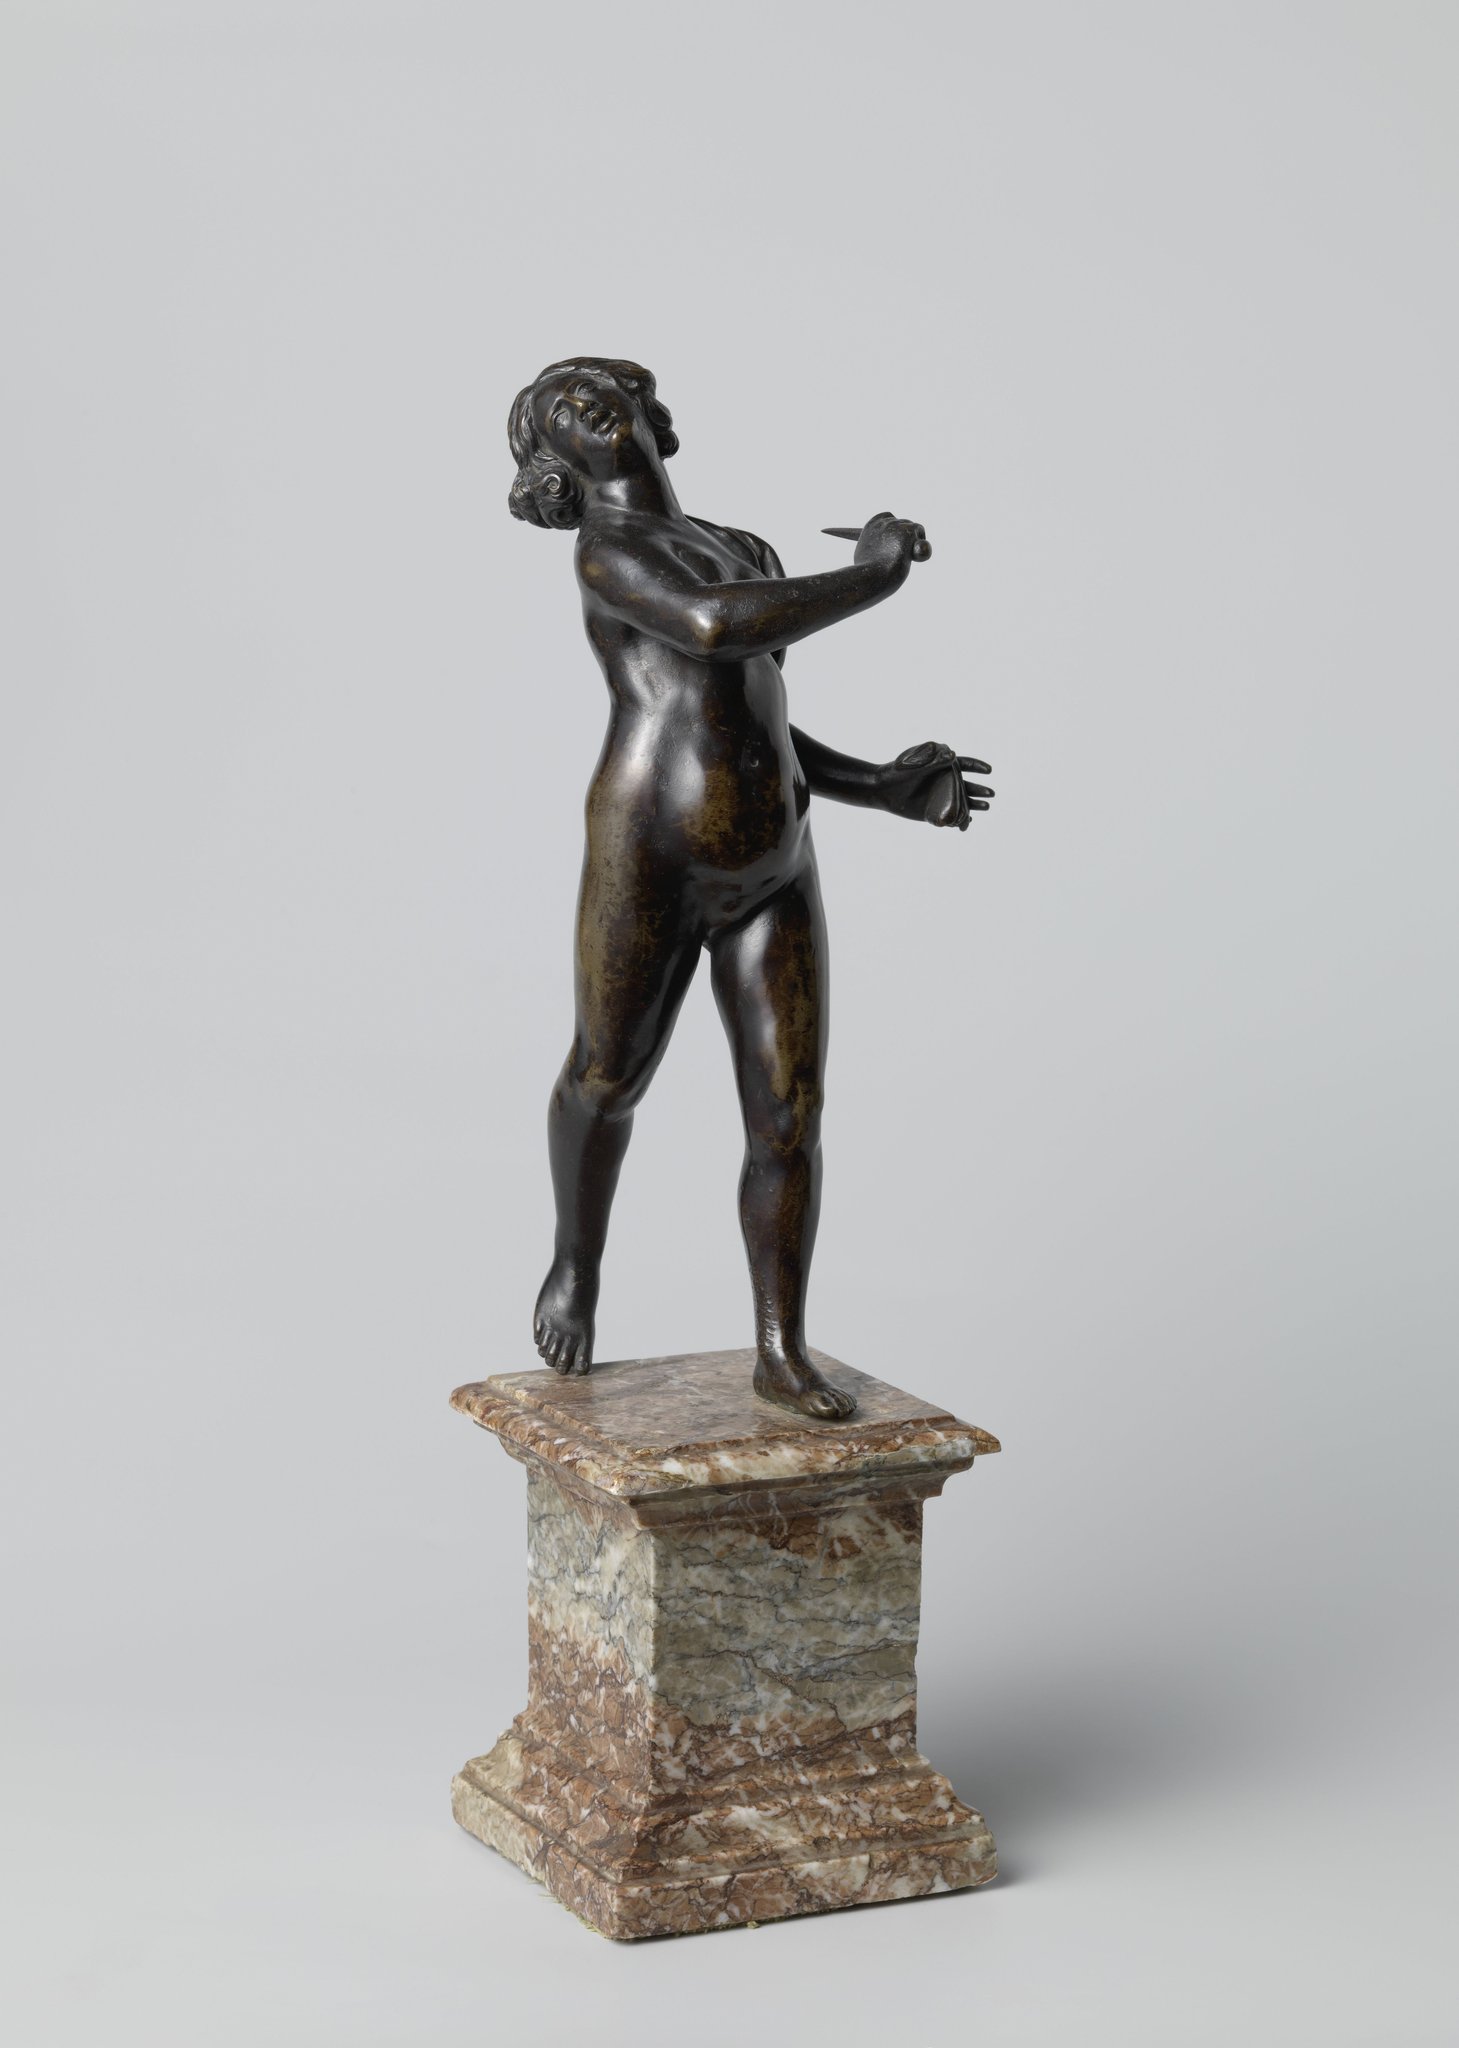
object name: figure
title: Dido (or Lucretia?)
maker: ferdinando tacca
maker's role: sculptor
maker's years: 1619-1686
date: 1660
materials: bronze, iron, marble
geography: florence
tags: (story of) dido - death, death of lucretia: she commits suicide by stabbing herself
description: Een lopende naakte vrouw in brons. Ze houdt met haar rechterhand een dolk voor haar borst. Haar linkerhand is zijwaarts gericht; het hoofd is afgewend (naar rechts) van de looprichting, alsof ze niet getuige wil zijn van haar aanstaande suïcidale daad. De vrouw draagt een klein kroontje in het haar. Het brons is gemonteerd op een rood/grijswit-geaderde, marmeren sokkel (19de-eeuws).